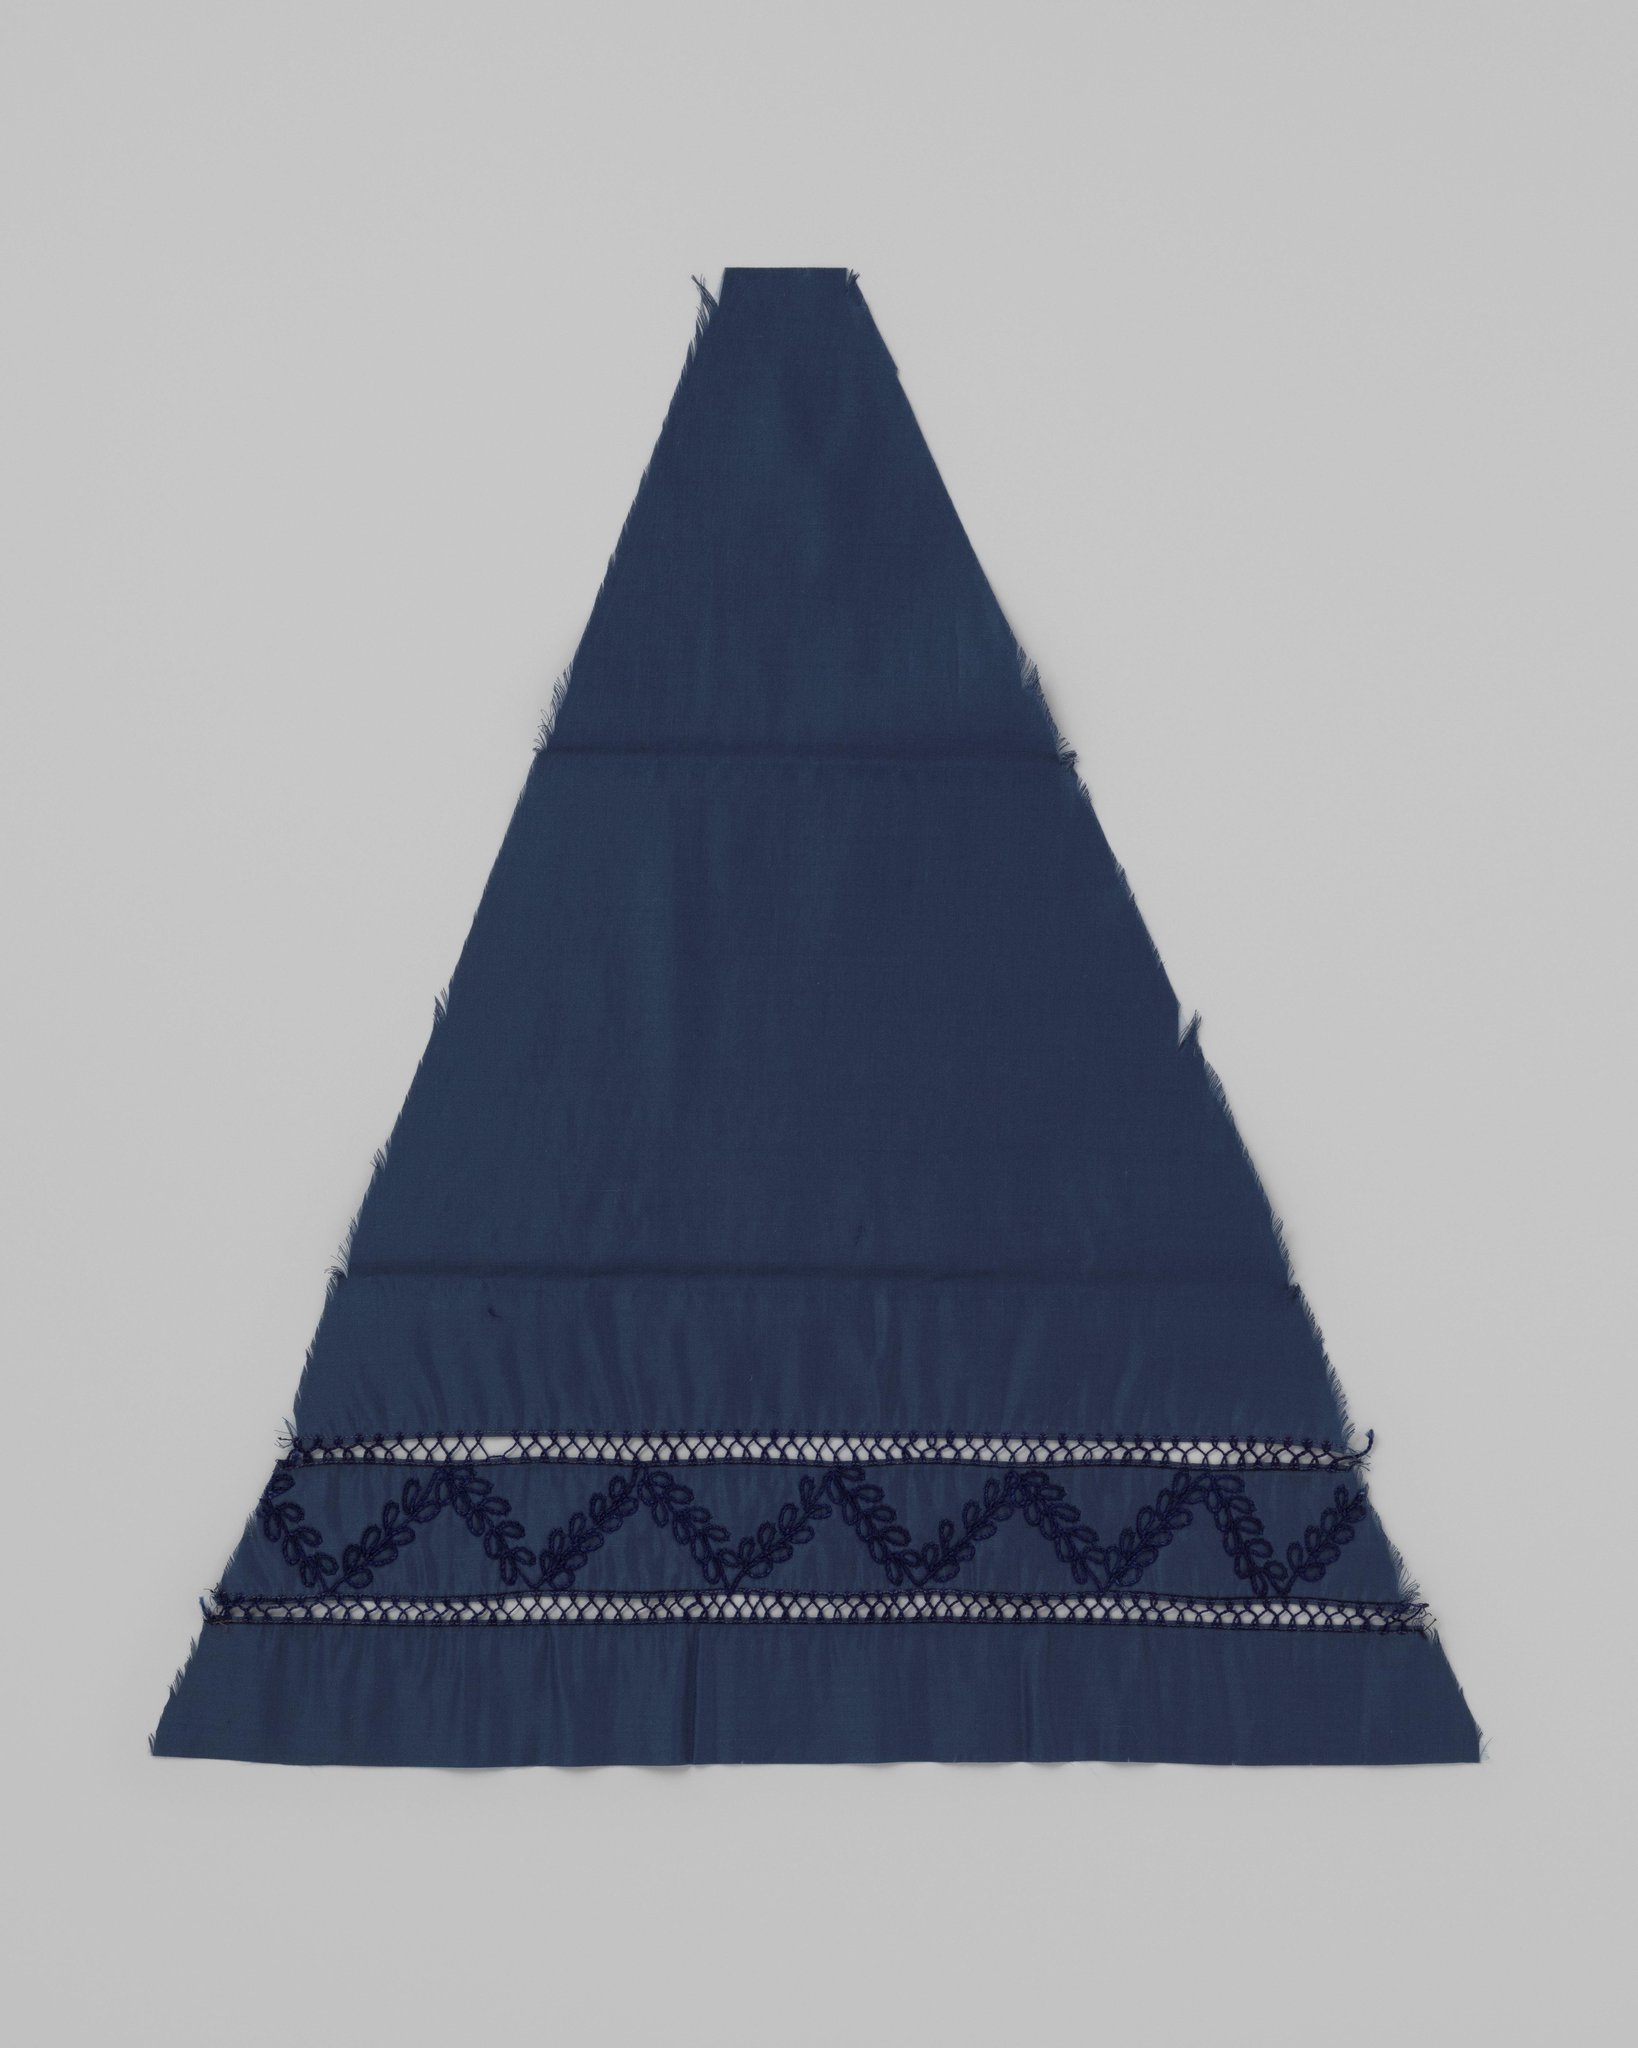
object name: parasoldek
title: Sector van een parasoldek van donkerblauwe katoen, versierd met borduurwerk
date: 1885-1900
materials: cotton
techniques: embroidered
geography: nijmegen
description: Sector van een parasoldek van donkerblauwe katoen, versierd met borduurwerk. Het borduurwerk bestaat uit twee rijen stiksteken doorgeregen met een flanelsteek, waartussen een slingerende bladrank. Aan het dek is een etiket bevestigd met een metalen klem.